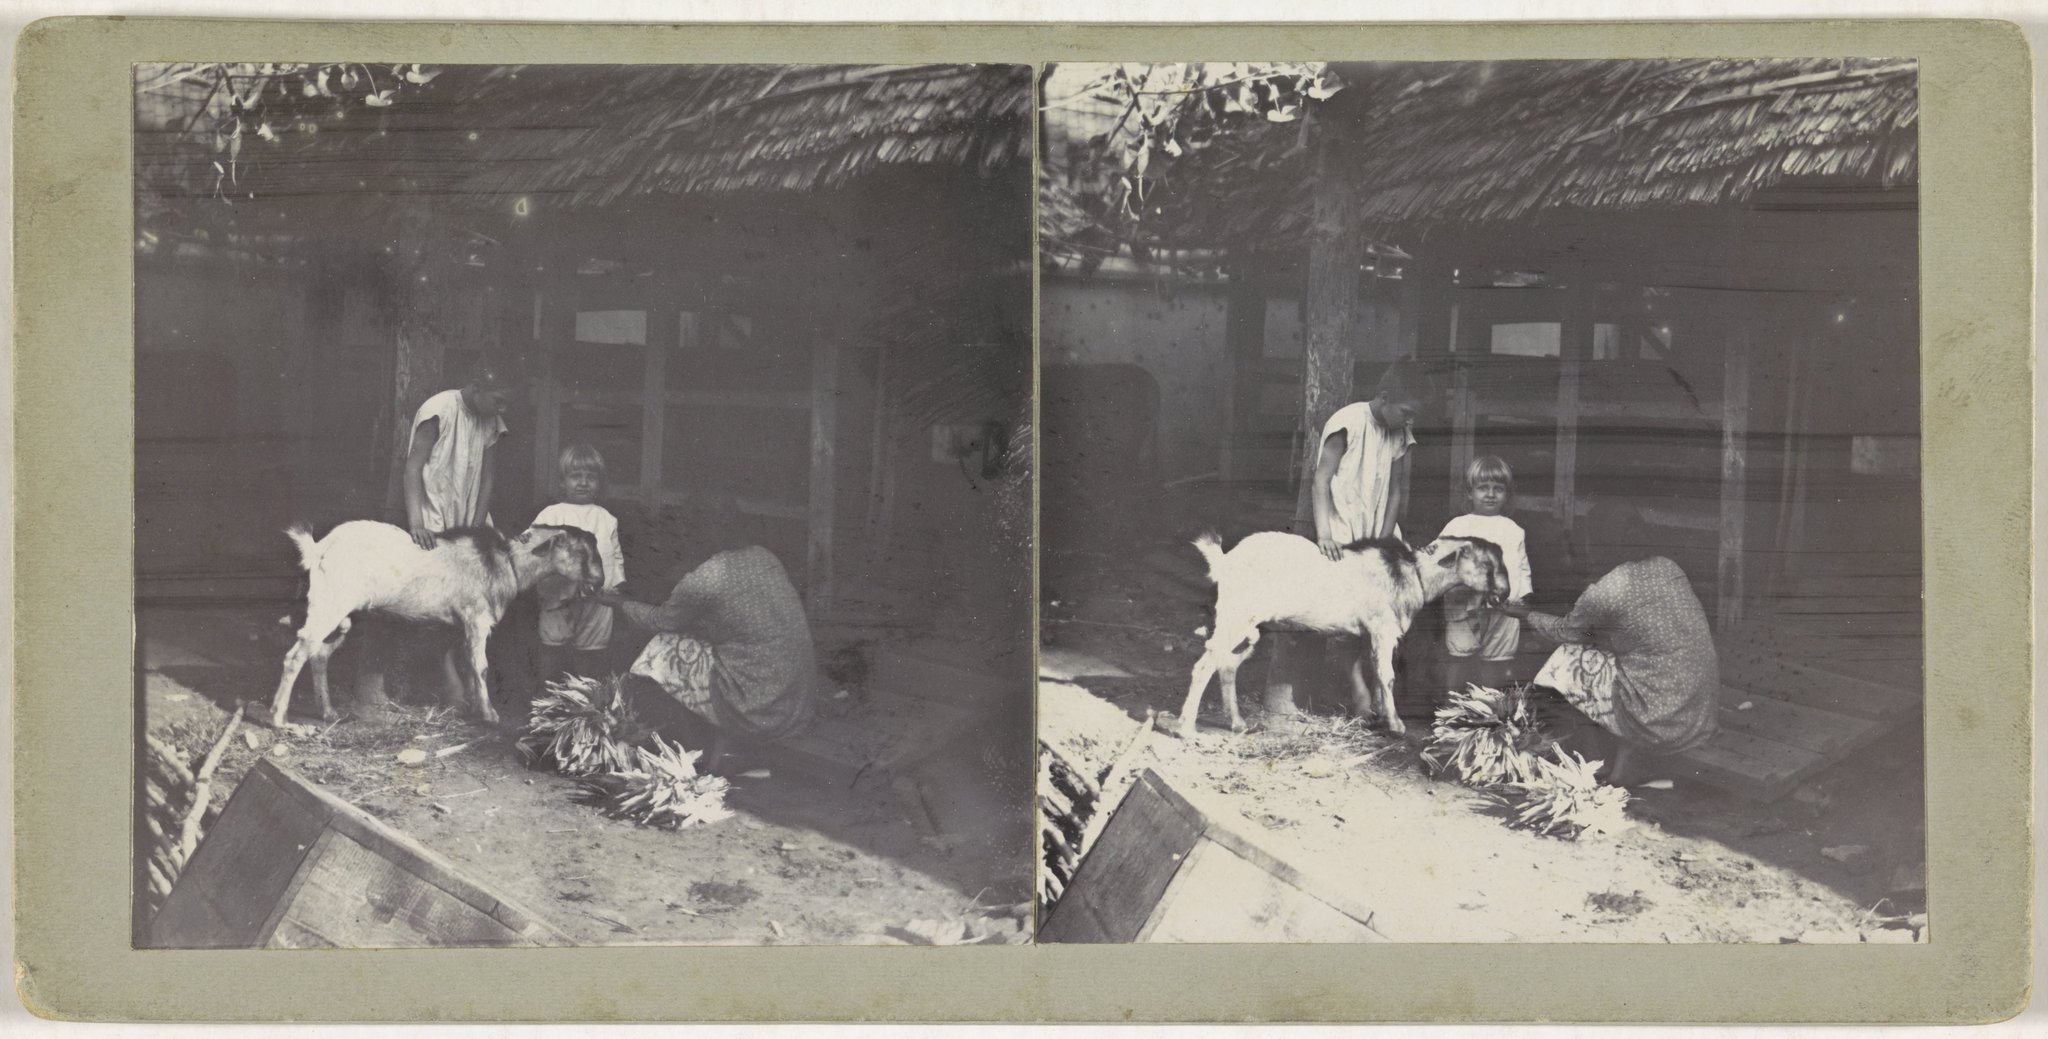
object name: stereograph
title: Vrouw en twee kinderen bij een geit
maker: Anonymous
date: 1906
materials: cardboard, paper, photographic support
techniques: albumen print